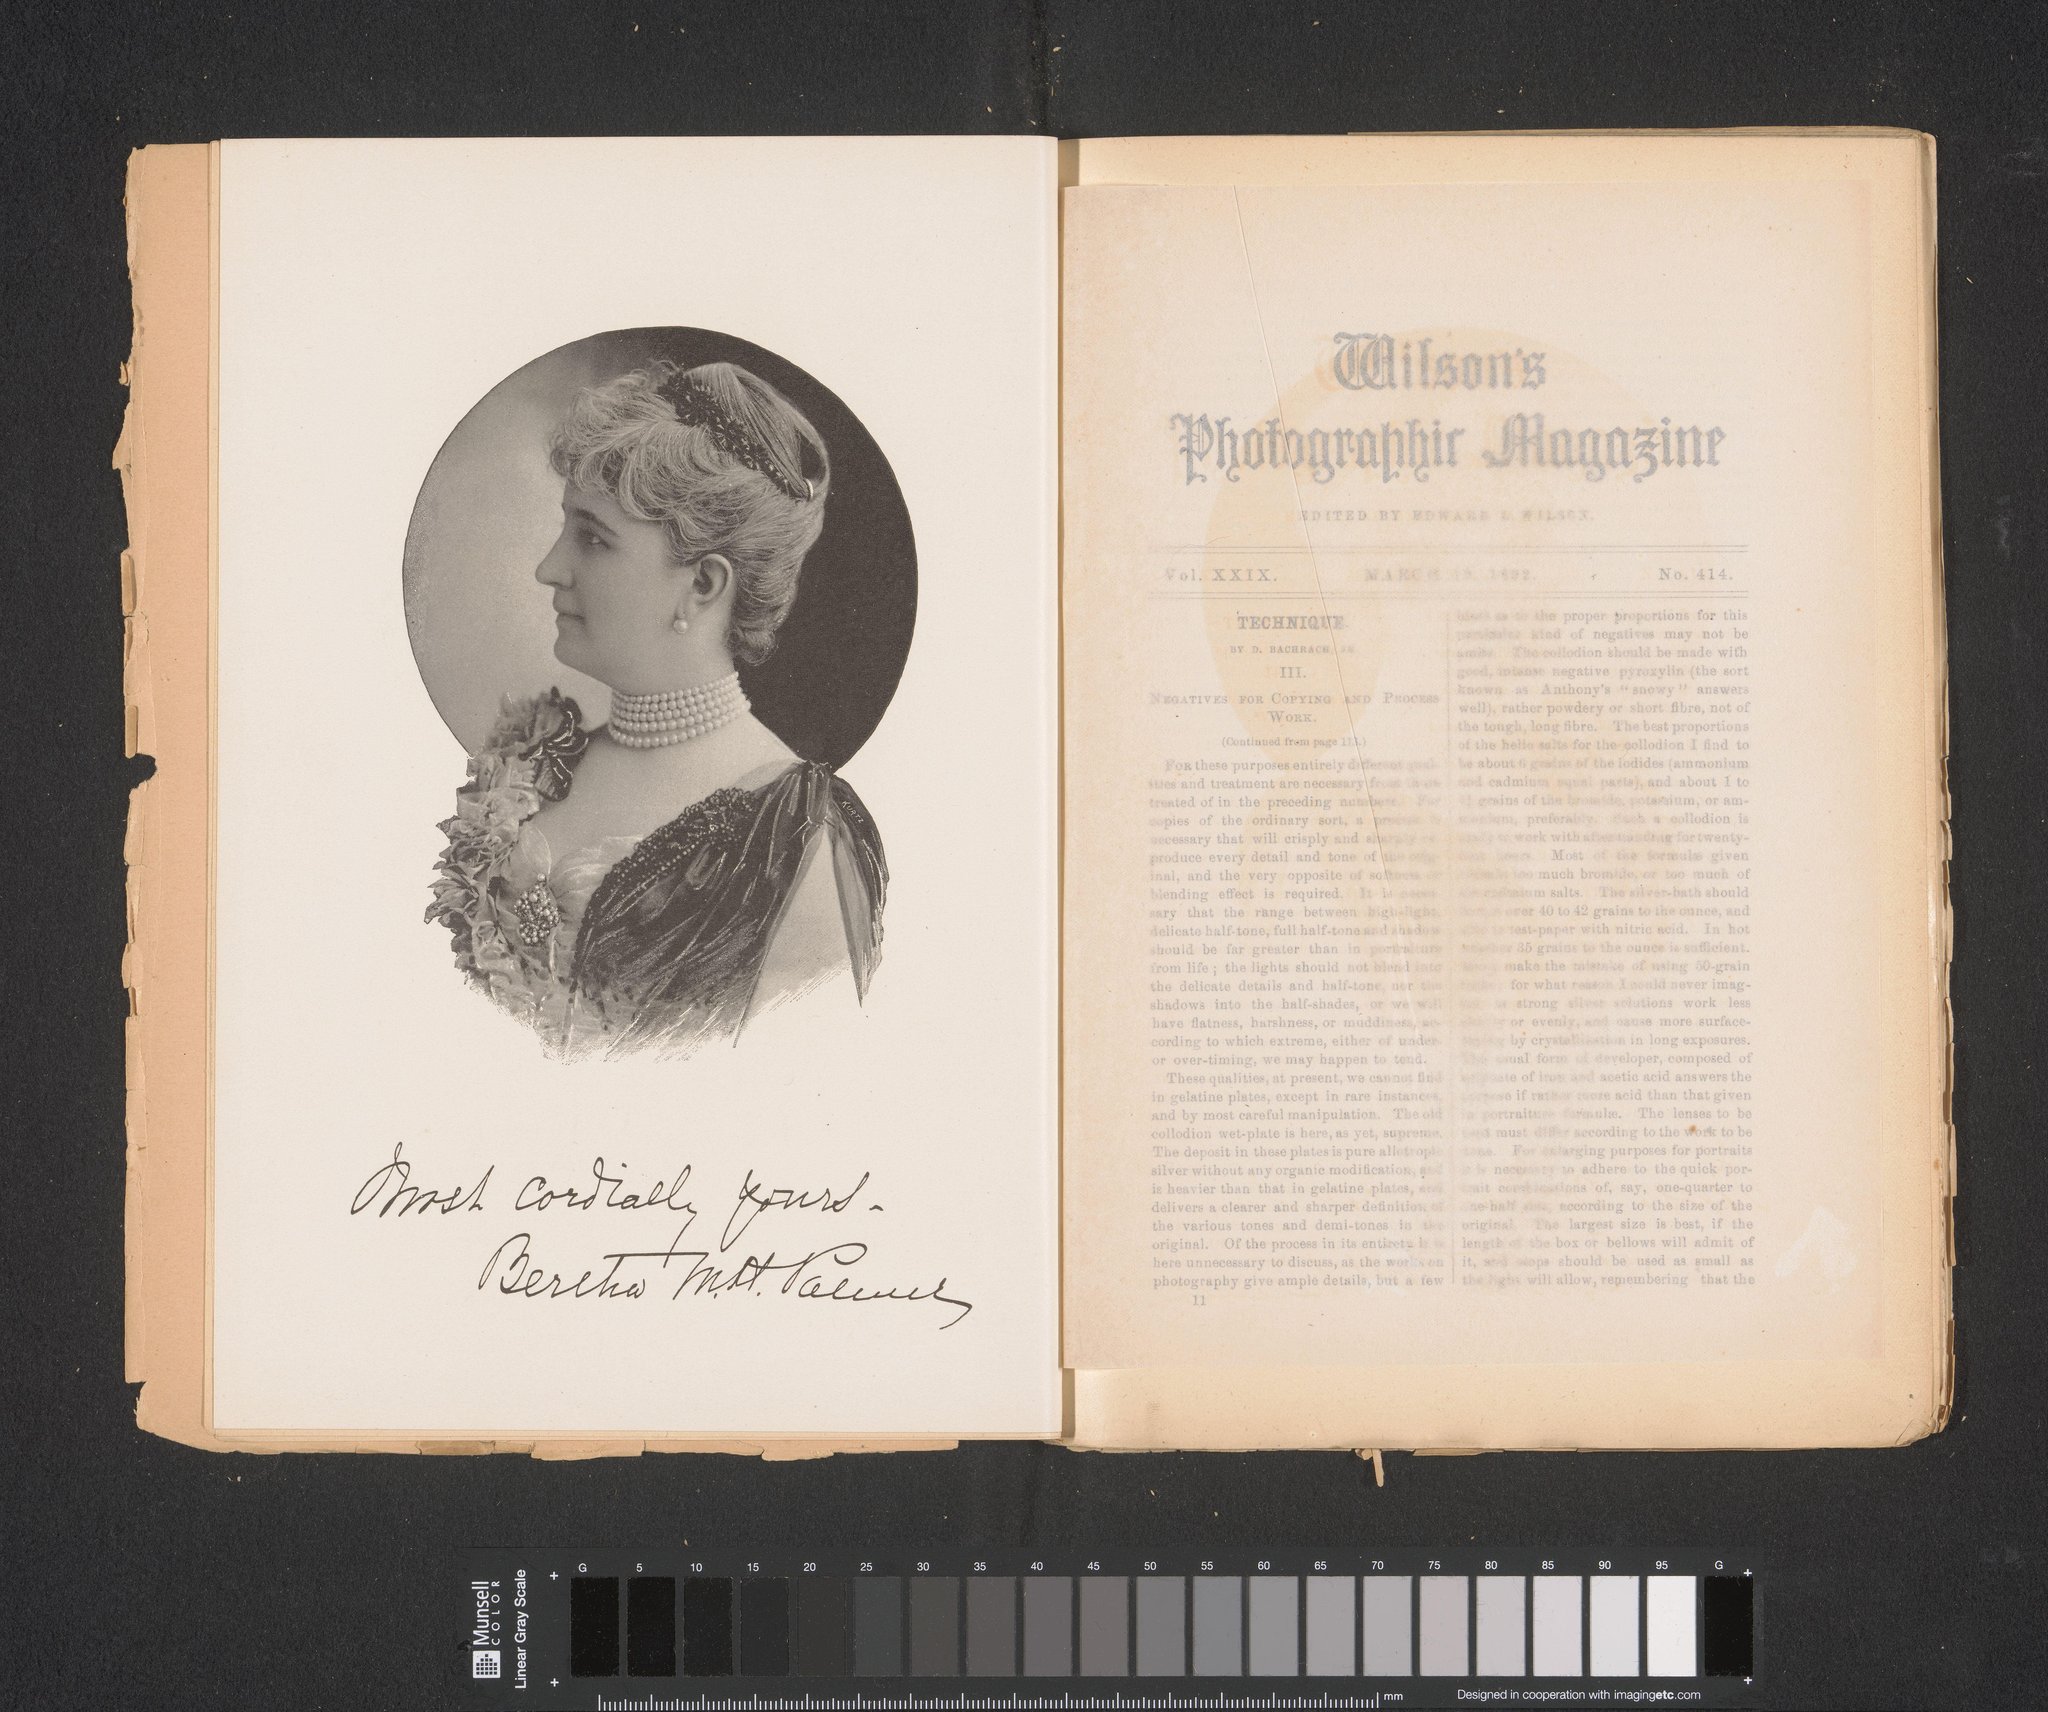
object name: page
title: Portret van een onbekende vrouw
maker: william kurtz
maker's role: fotograaf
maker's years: 1833-1904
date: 1887-1892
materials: paper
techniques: autotype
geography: new york city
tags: historical persons not known by name - bb - woman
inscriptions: inscription: ‘Most cordially yours./ Ber[..]a M.[..] Palmer’